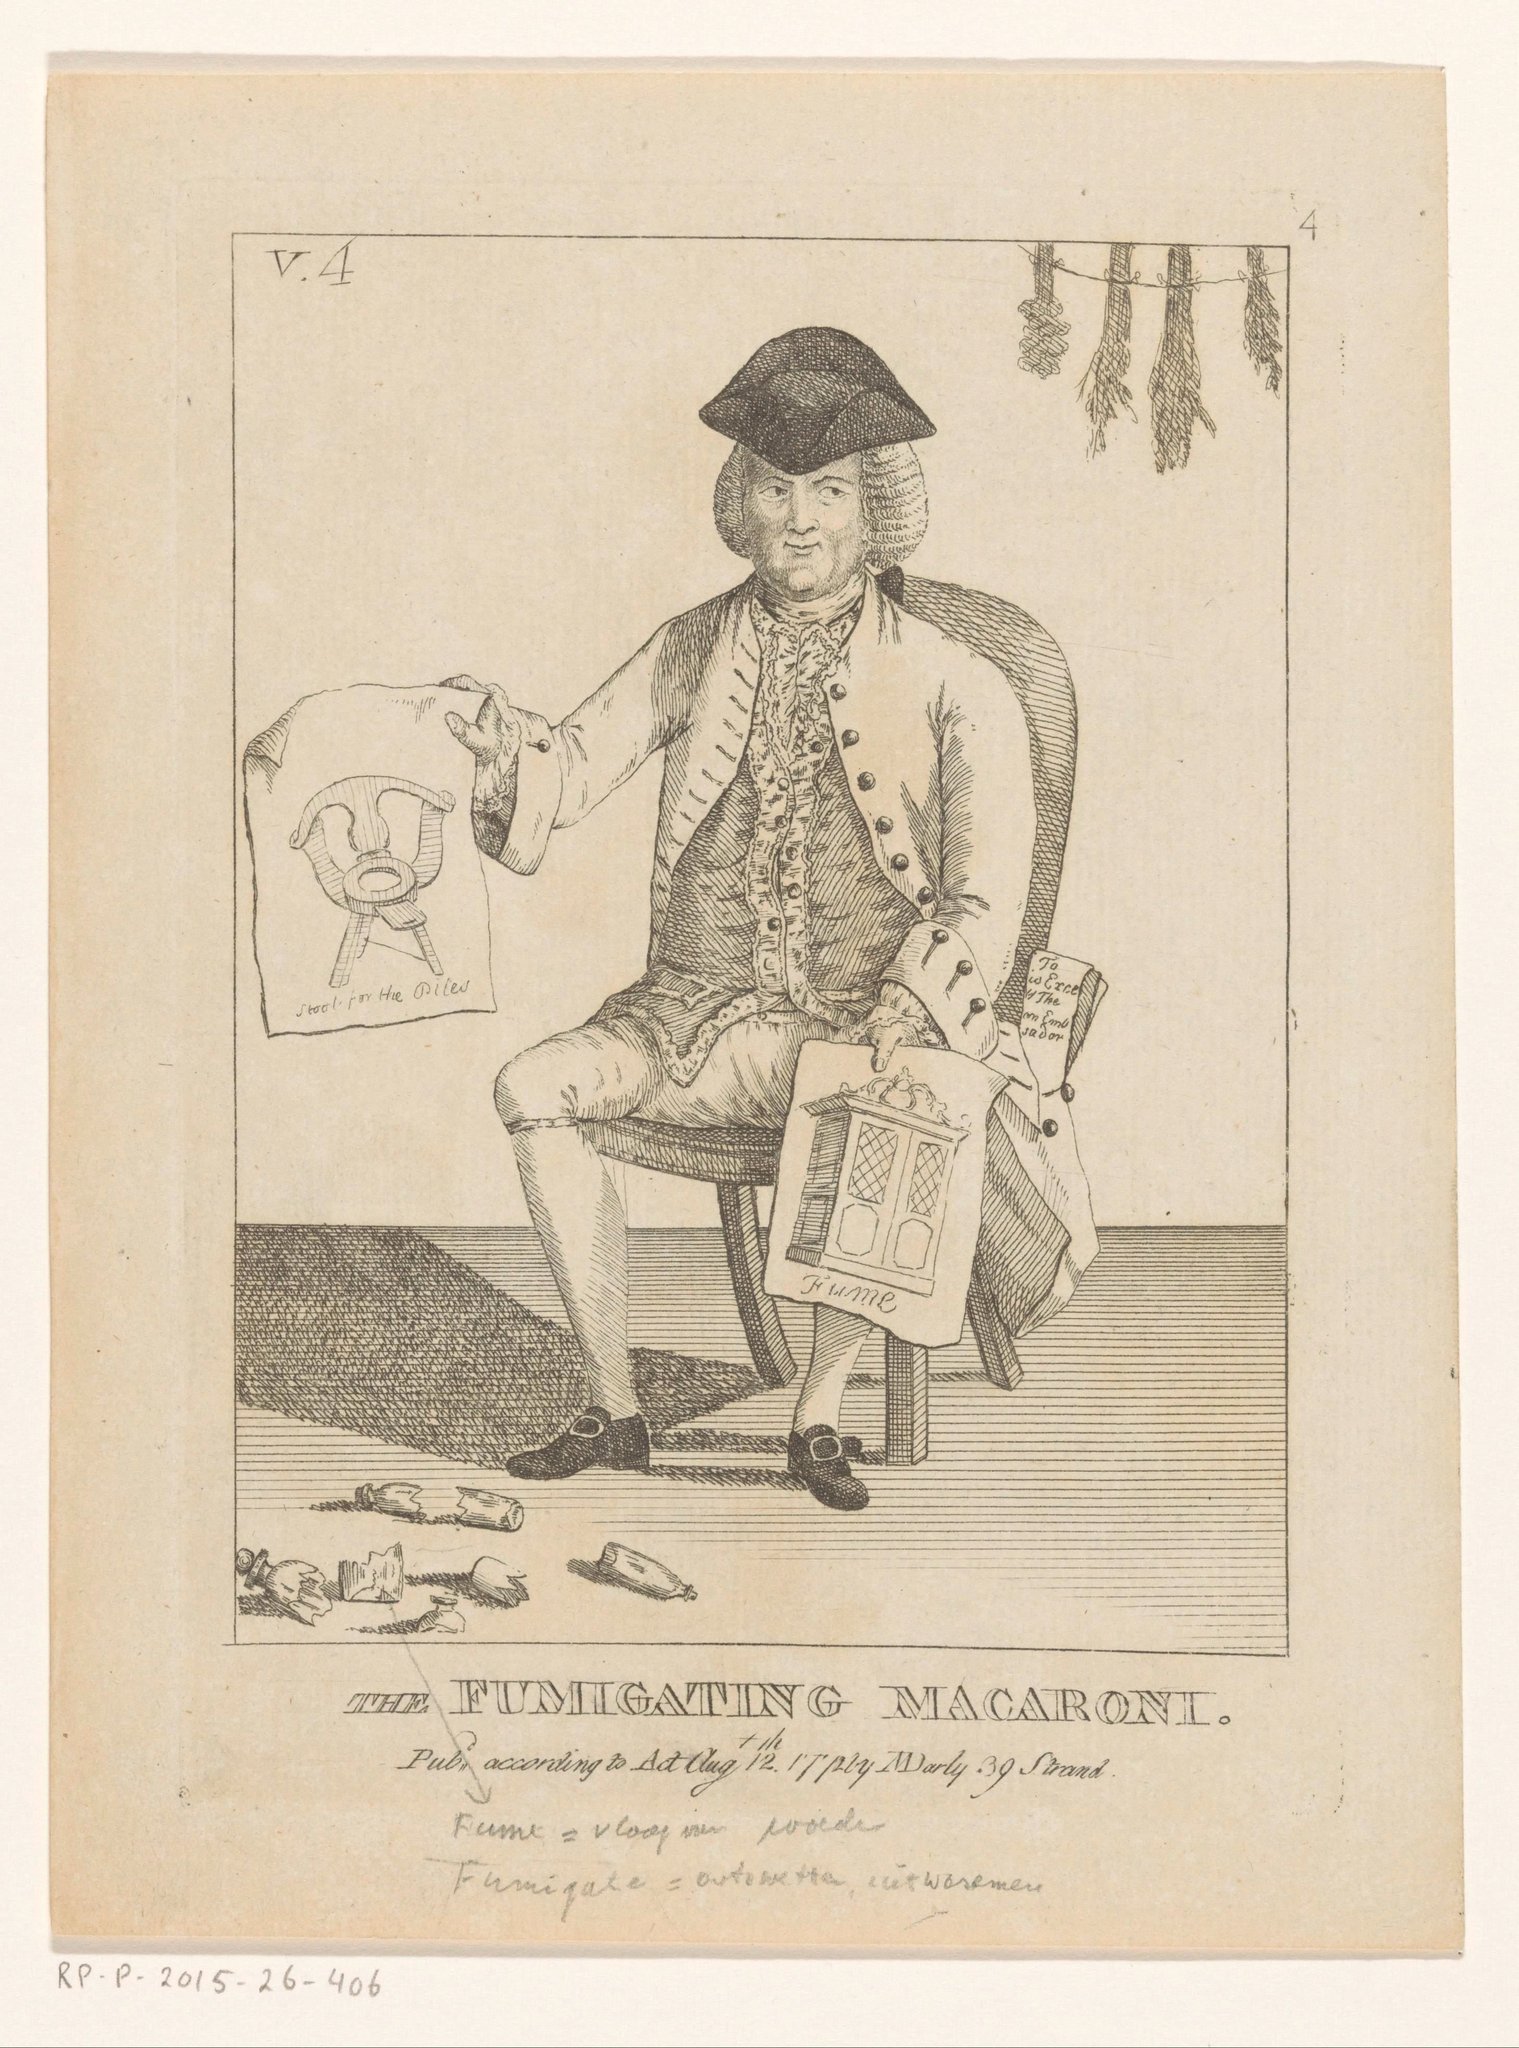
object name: print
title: Macaronies, Characters, Caricatures &c.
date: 1772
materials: paper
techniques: etching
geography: london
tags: caricatures (human types), print, e.g.: engraving, etching, lithograph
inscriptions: collector's mark: Lugt 2228, collector's mark: Lugt 4780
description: Afkomstig uit de vierde serie van zes, getiteld: Macaronies, Characters, Caricatures &cd, uitgegeven door Matthew Darly in Londen tussen 1771 en 1773. De term 'macaroni' werd gebruikt in Engeland in de tweede helft van de 18de eeuw voor personen die op een overdreven wijze de laatste mode volgden. In zekere zin vormden zij de voorlopers van de dandy's.